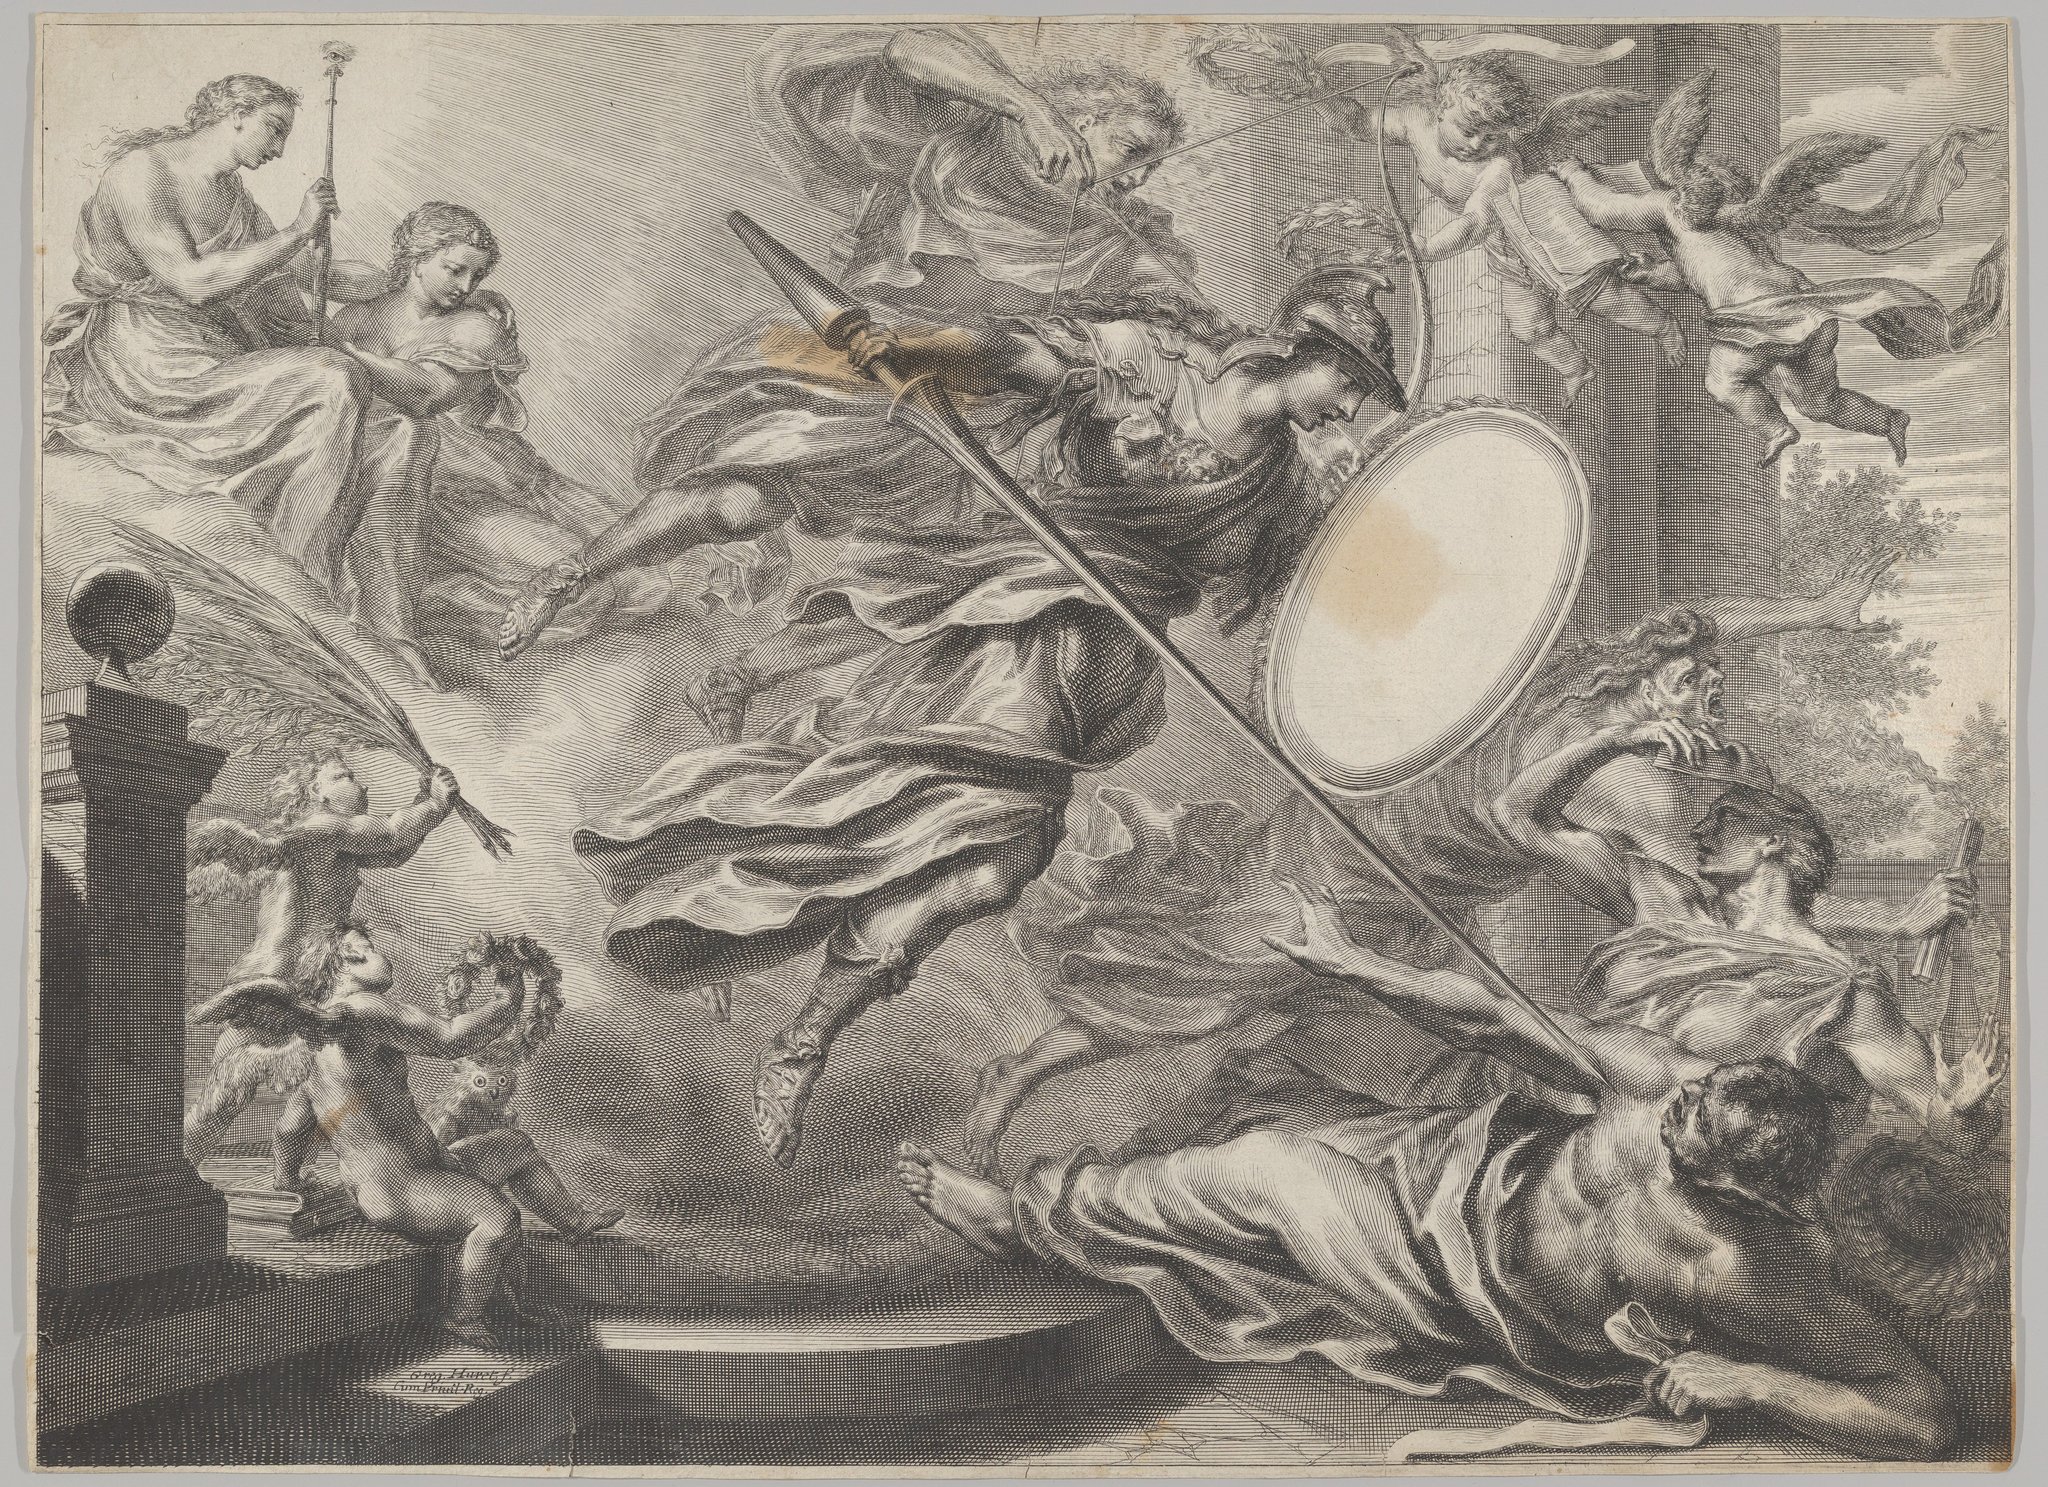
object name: print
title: Minerva armed with a shield and lance attacking three nearly prone figures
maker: grégoire huret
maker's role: artist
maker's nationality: french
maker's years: 1606-1670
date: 1601-1700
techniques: engraving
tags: shields,women,minerva